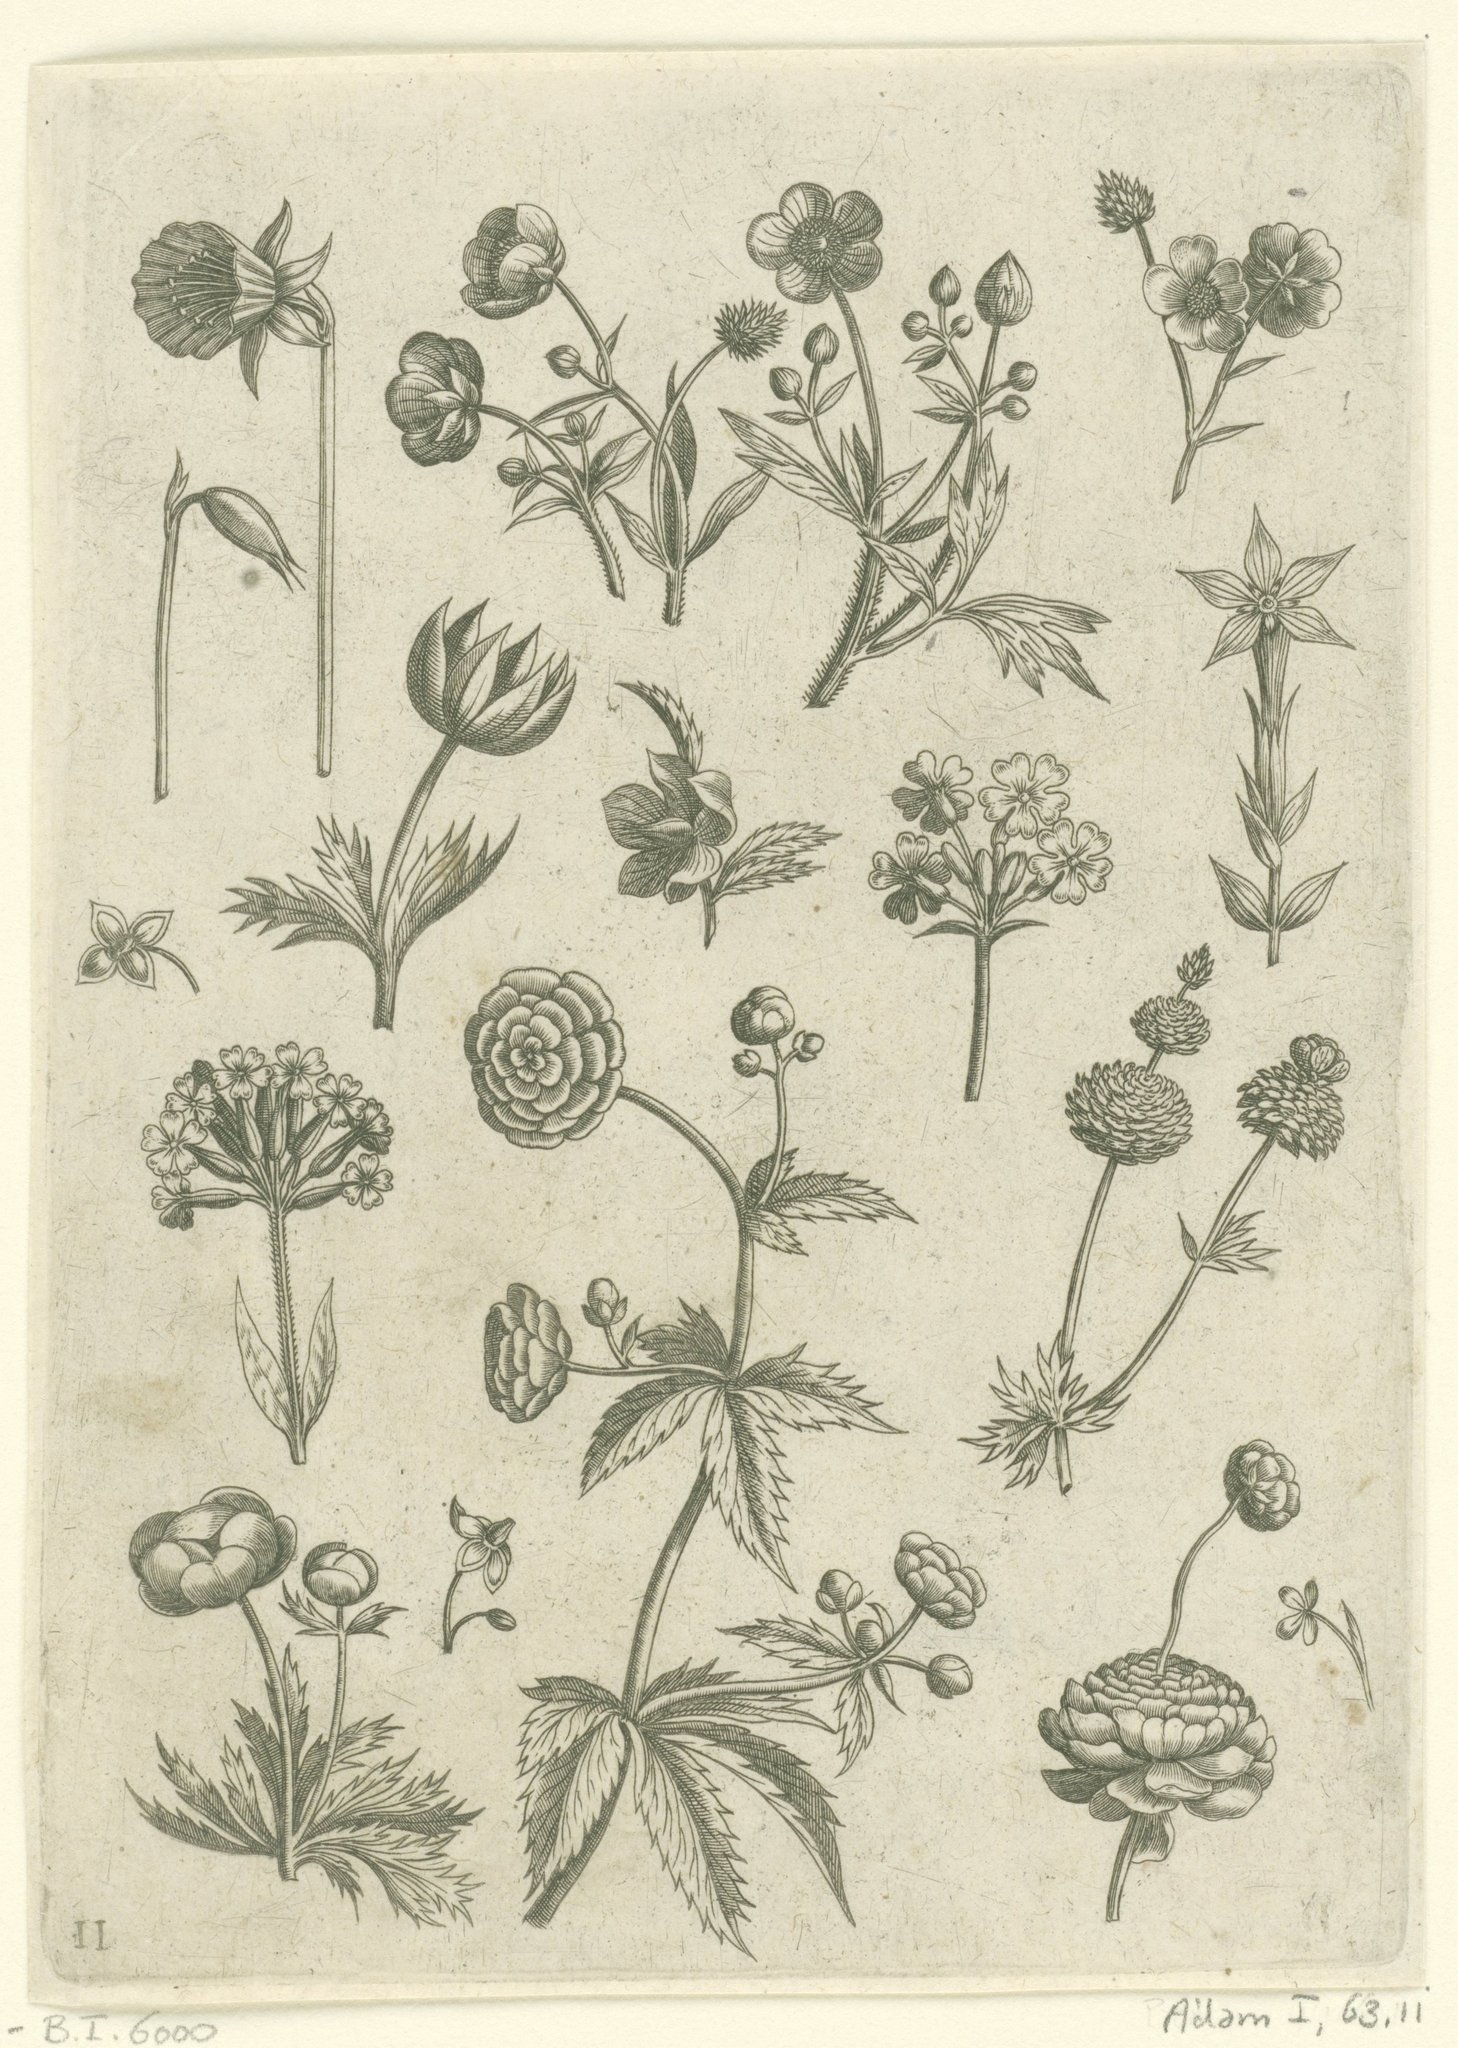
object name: ornament print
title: Ranonkels, primula en boterbloemen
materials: paper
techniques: engraving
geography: netherlands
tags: flowers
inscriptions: collector's mark: Lugt 240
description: Blad 11 van 21 genummerde bladen met titelblad afkomstig uit een serie van 24.